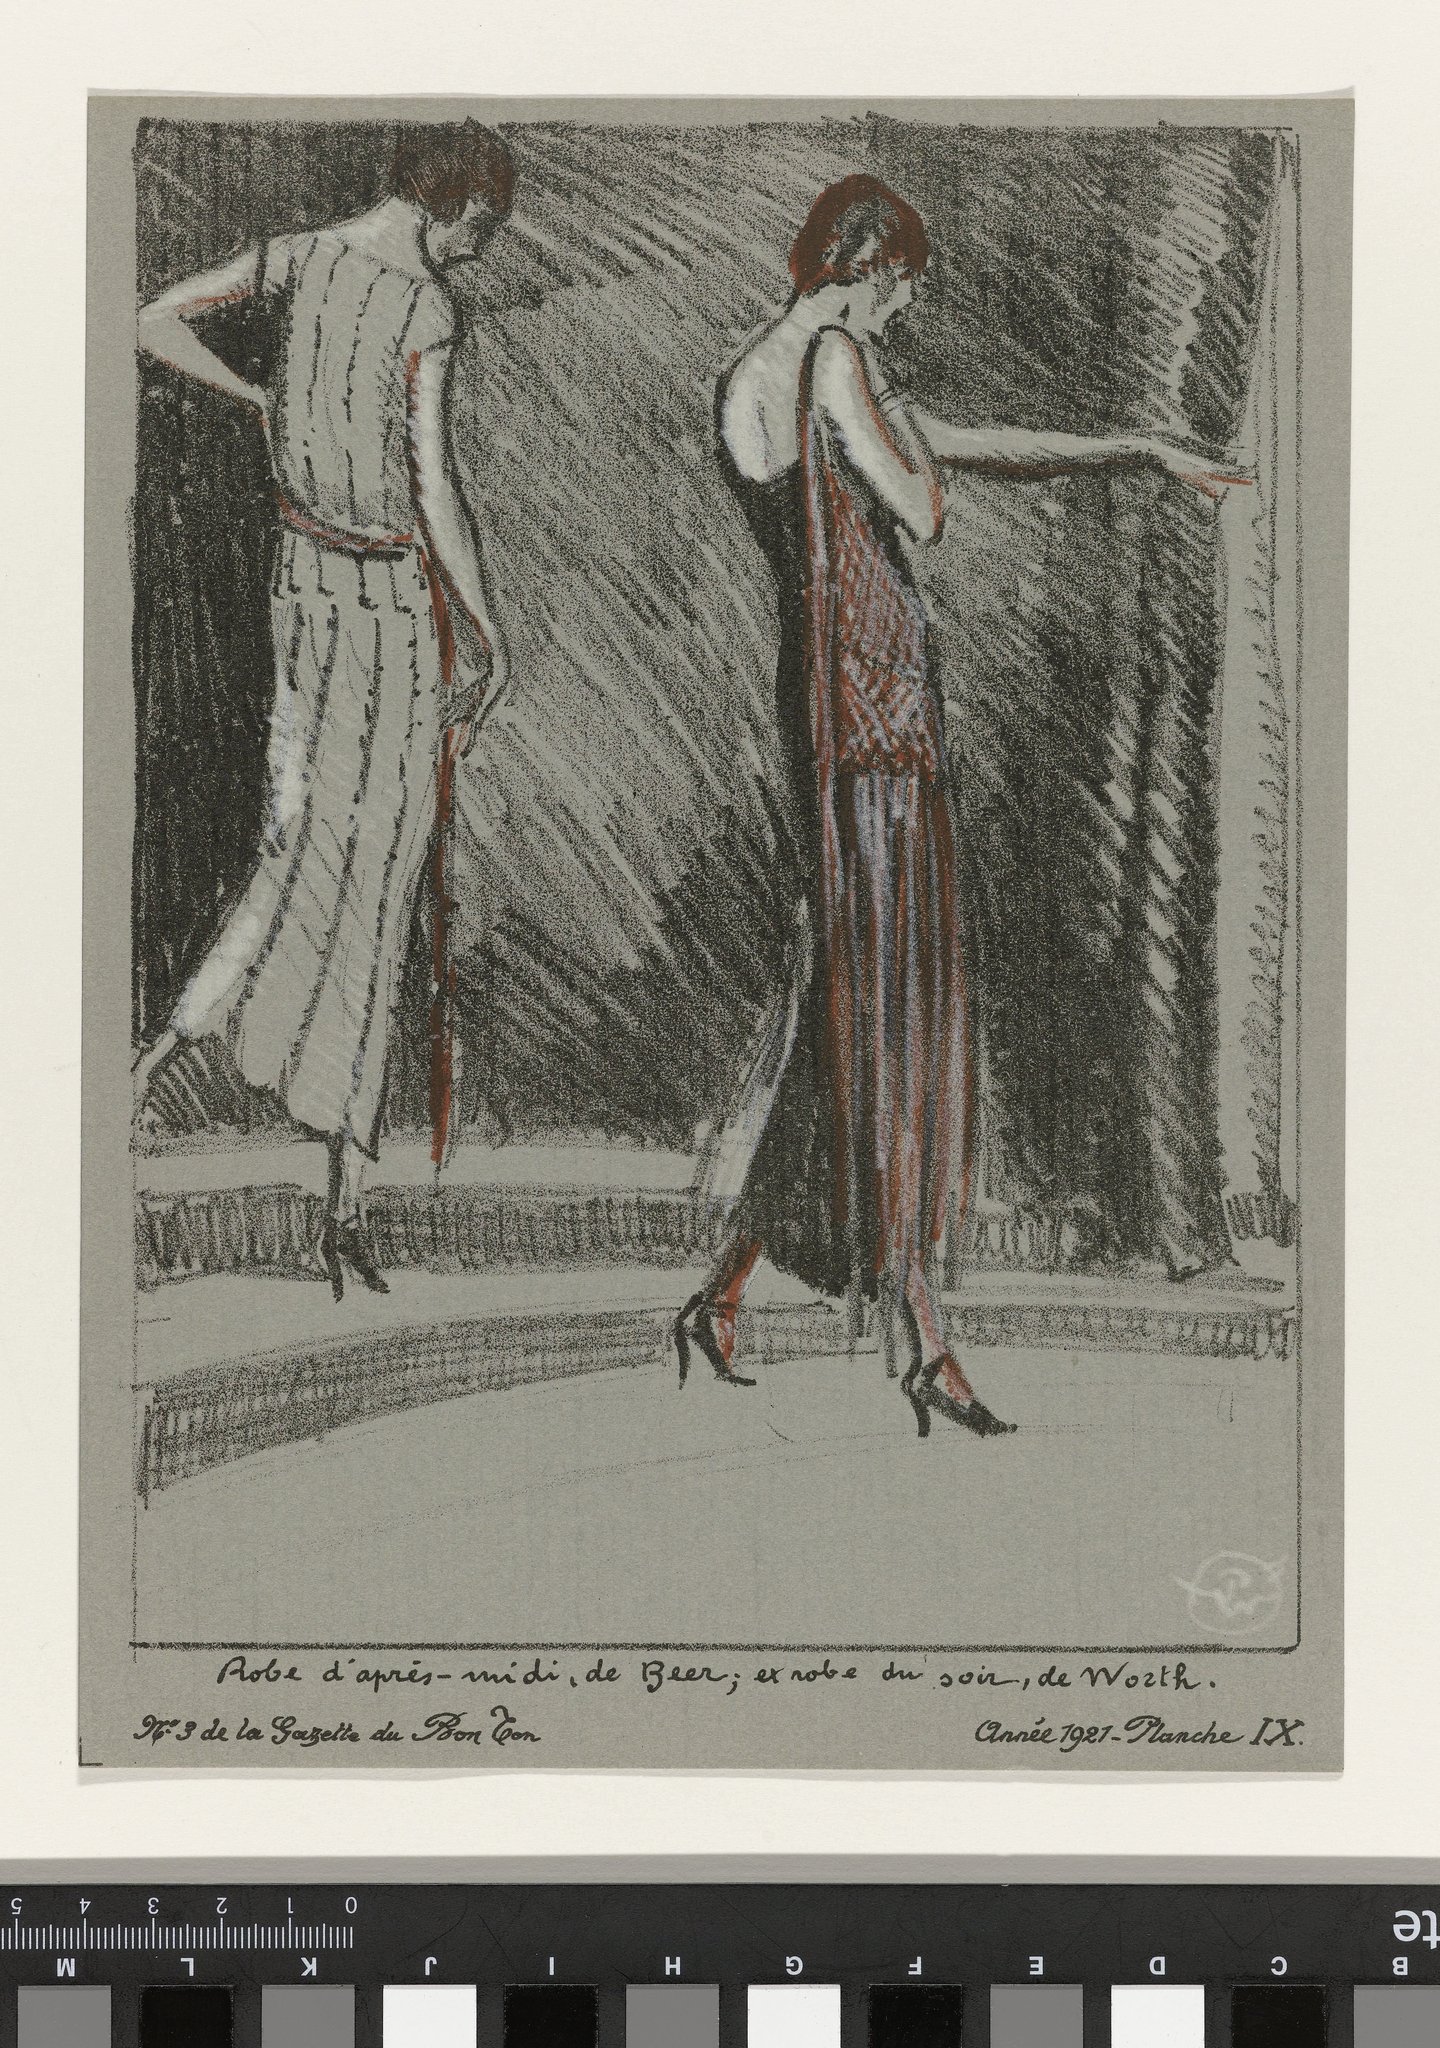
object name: fashion print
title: Gazette du Bon Ton, 1921 - No. 3, Pl. IX: Robe d'après-midi, de Beer; et robe du soir, de Worth.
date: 1921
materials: paper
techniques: lithograph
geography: geneva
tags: dress, gown: evening dress (+ women's clothes), fashion plates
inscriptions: date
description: Twee vrouwen, op de rug gezien, gekleed in een middagjapon van Beer en een avondjapon van Worth, lopend op een trap in een uitgaansgelegenheid. Planche IX uit een serie van vier litho's getiteld: 'Les modes en l'an de grace mil neuf cent vingt un', uit Gazette du Bon Ton 1921, No. 3. Uitleg over de kleding op pagina "Explication des Planches".